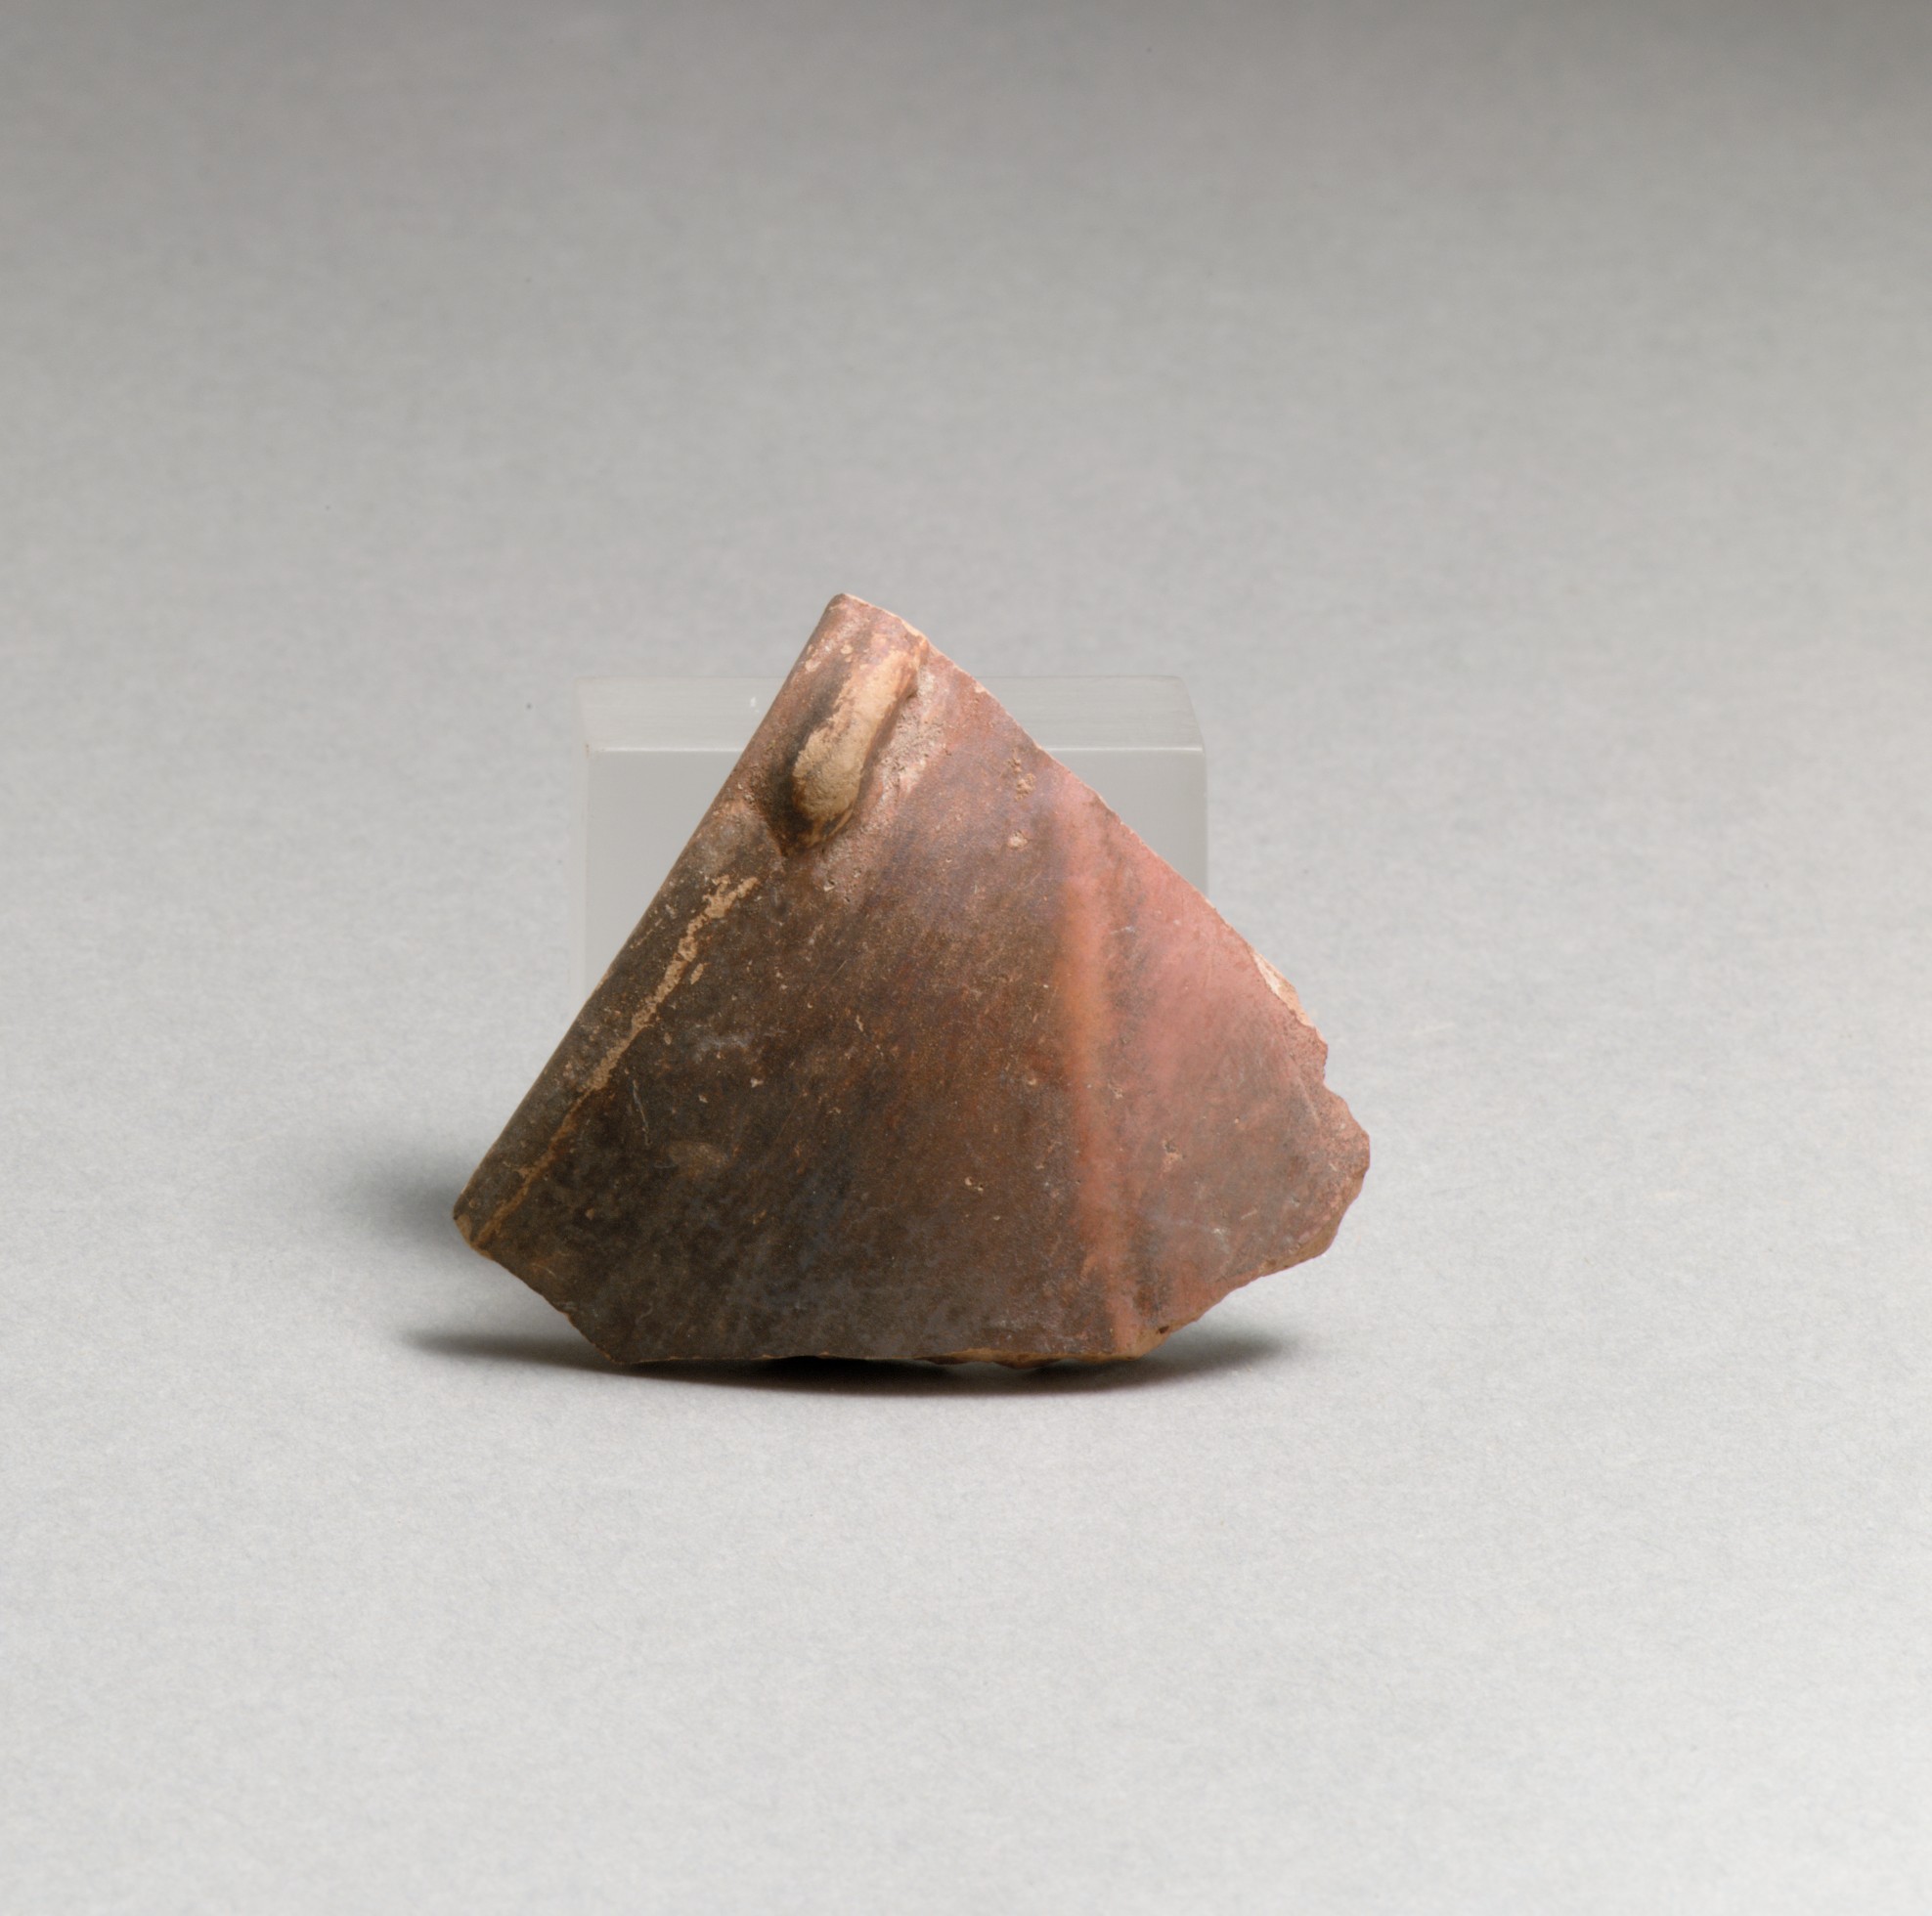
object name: vase fragment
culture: minoan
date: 2600-2000 BCE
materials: terracotta